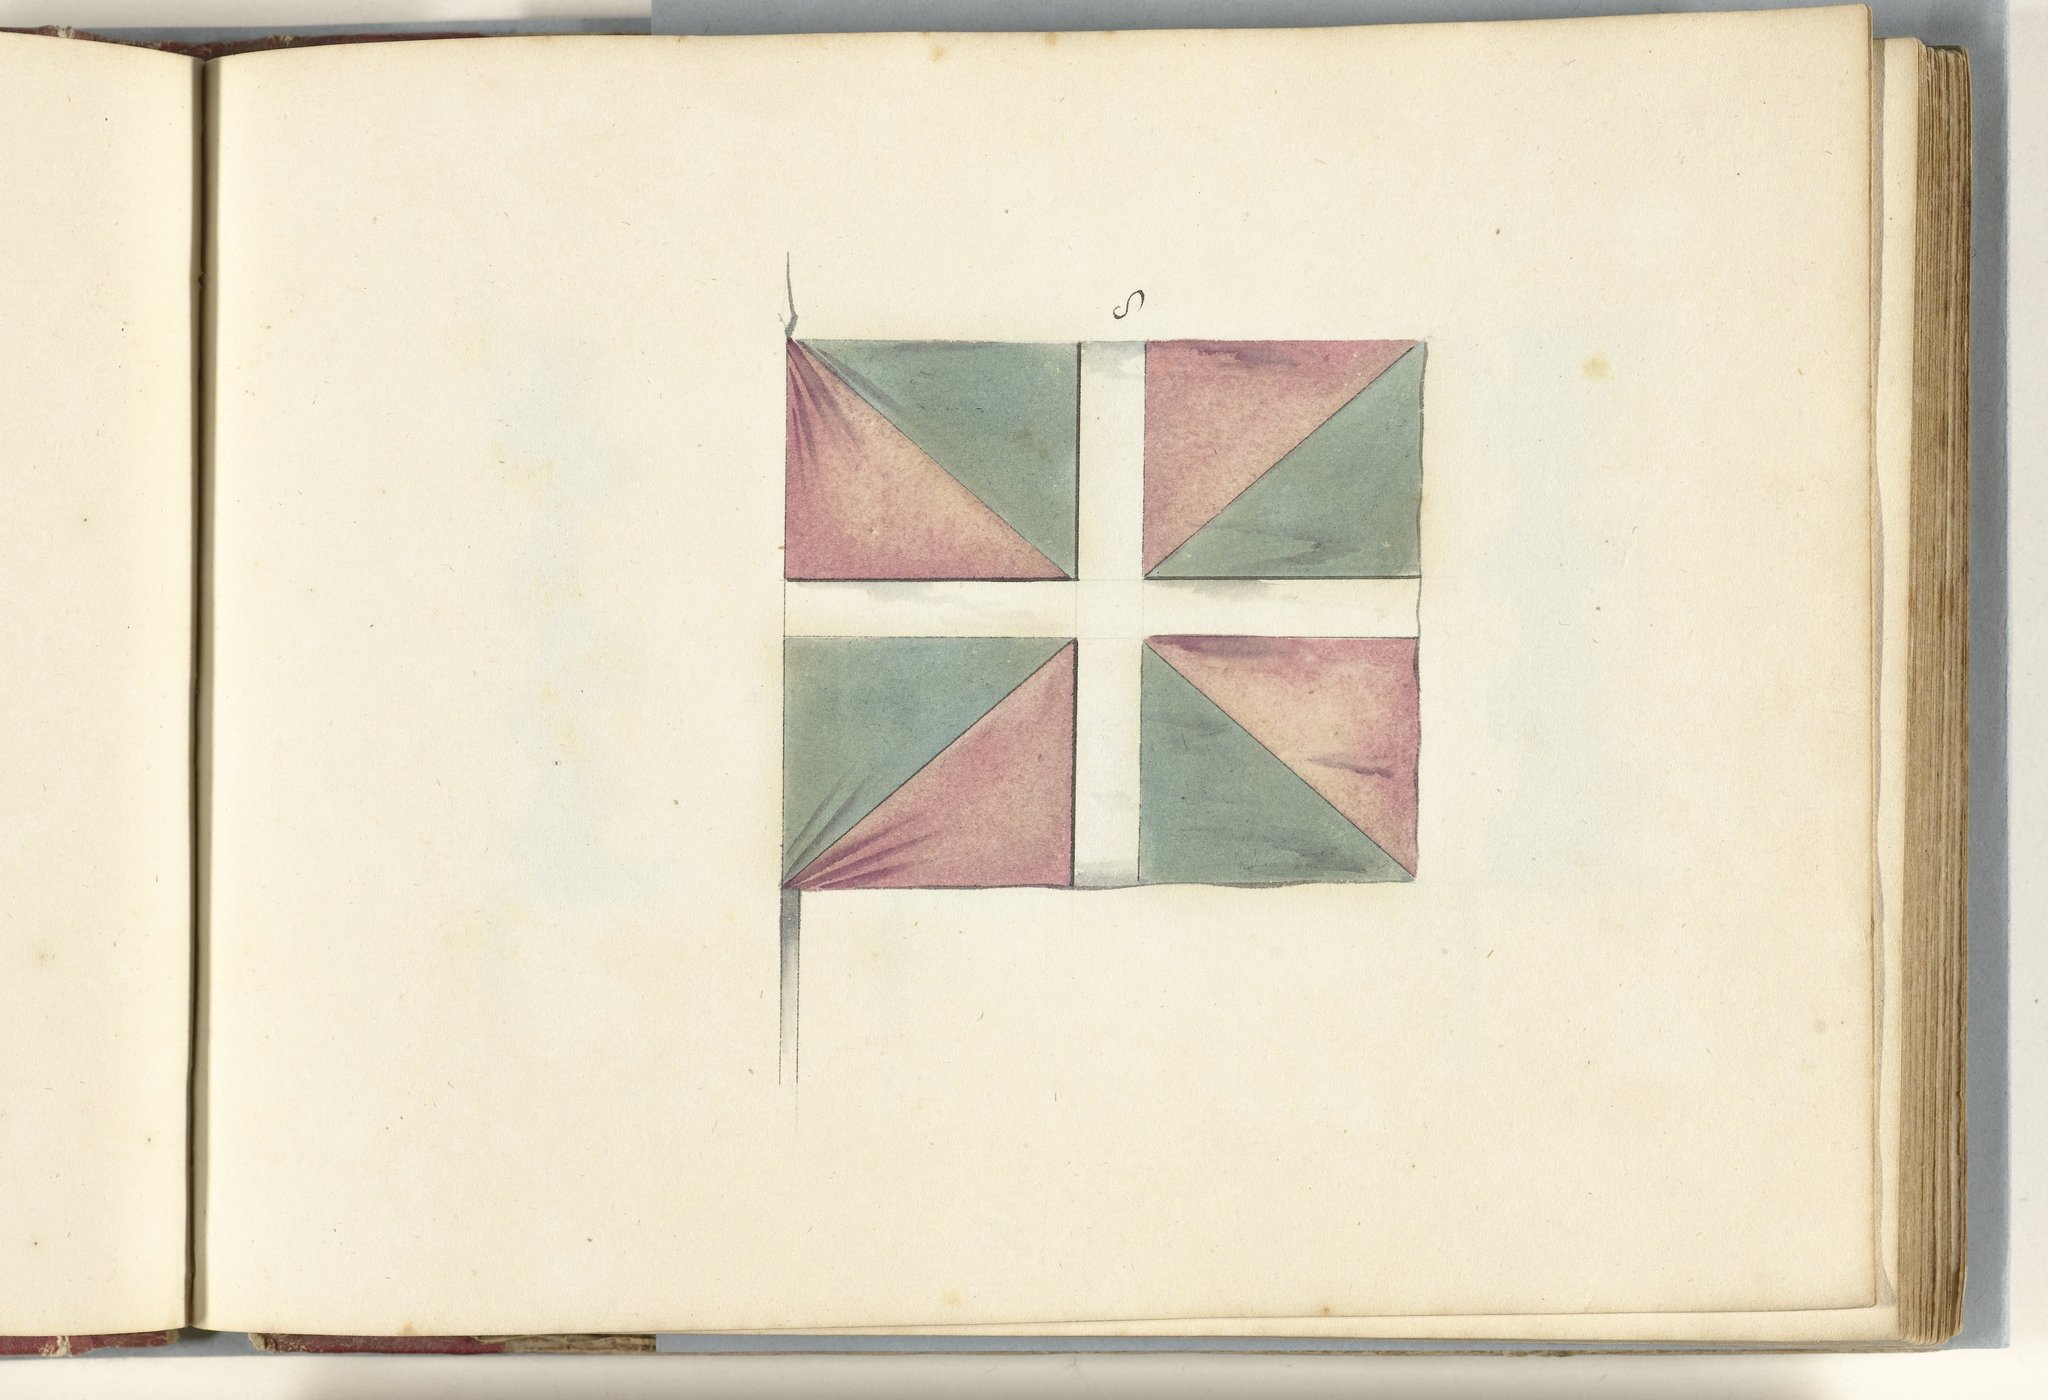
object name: drawing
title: Frans vaandel veroverd in de slag bij Oudenaarde, 1708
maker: Anonymous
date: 1713-1720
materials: paper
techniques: drawing, writing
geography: northern netherlands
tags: (military) flags and standards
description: Frans vaandel veroverd bij de slag bij Oudenaarde in 1708. In het boek met tekeningen van Franse vaandels, standaarden en pauken, veroverd tijdens de Spaanse Successieoorlog (1701-1713).